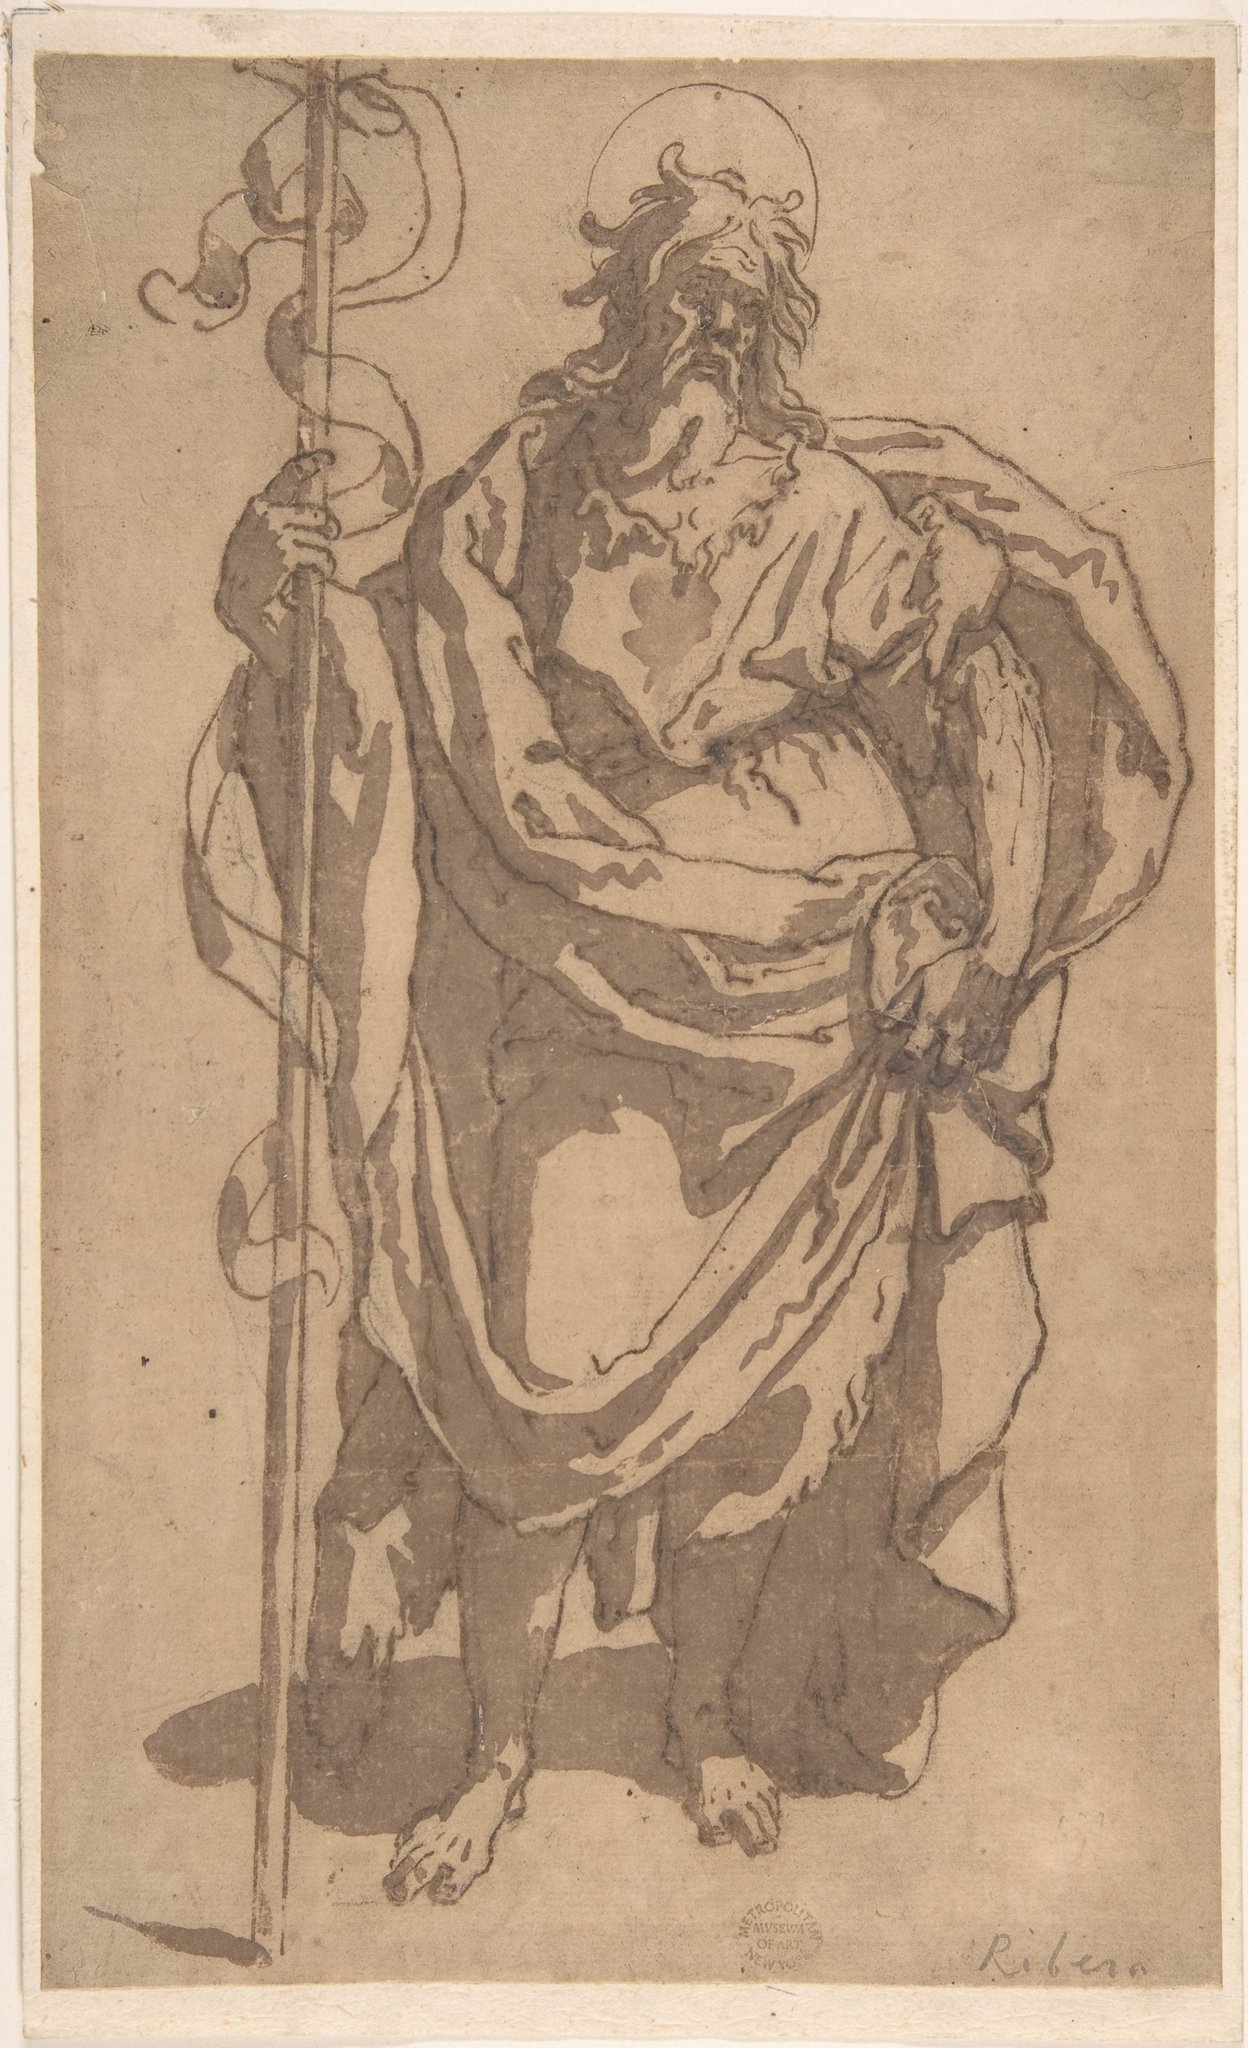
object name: drawing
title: Saint John the Baptist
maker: anonymous, italian, roman-bolognese, 17th century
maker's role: artist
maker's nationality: italian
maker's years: 1600-1700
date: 1601-1700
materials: ink, paper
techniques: brush, pen, wash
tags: saint john the baptist